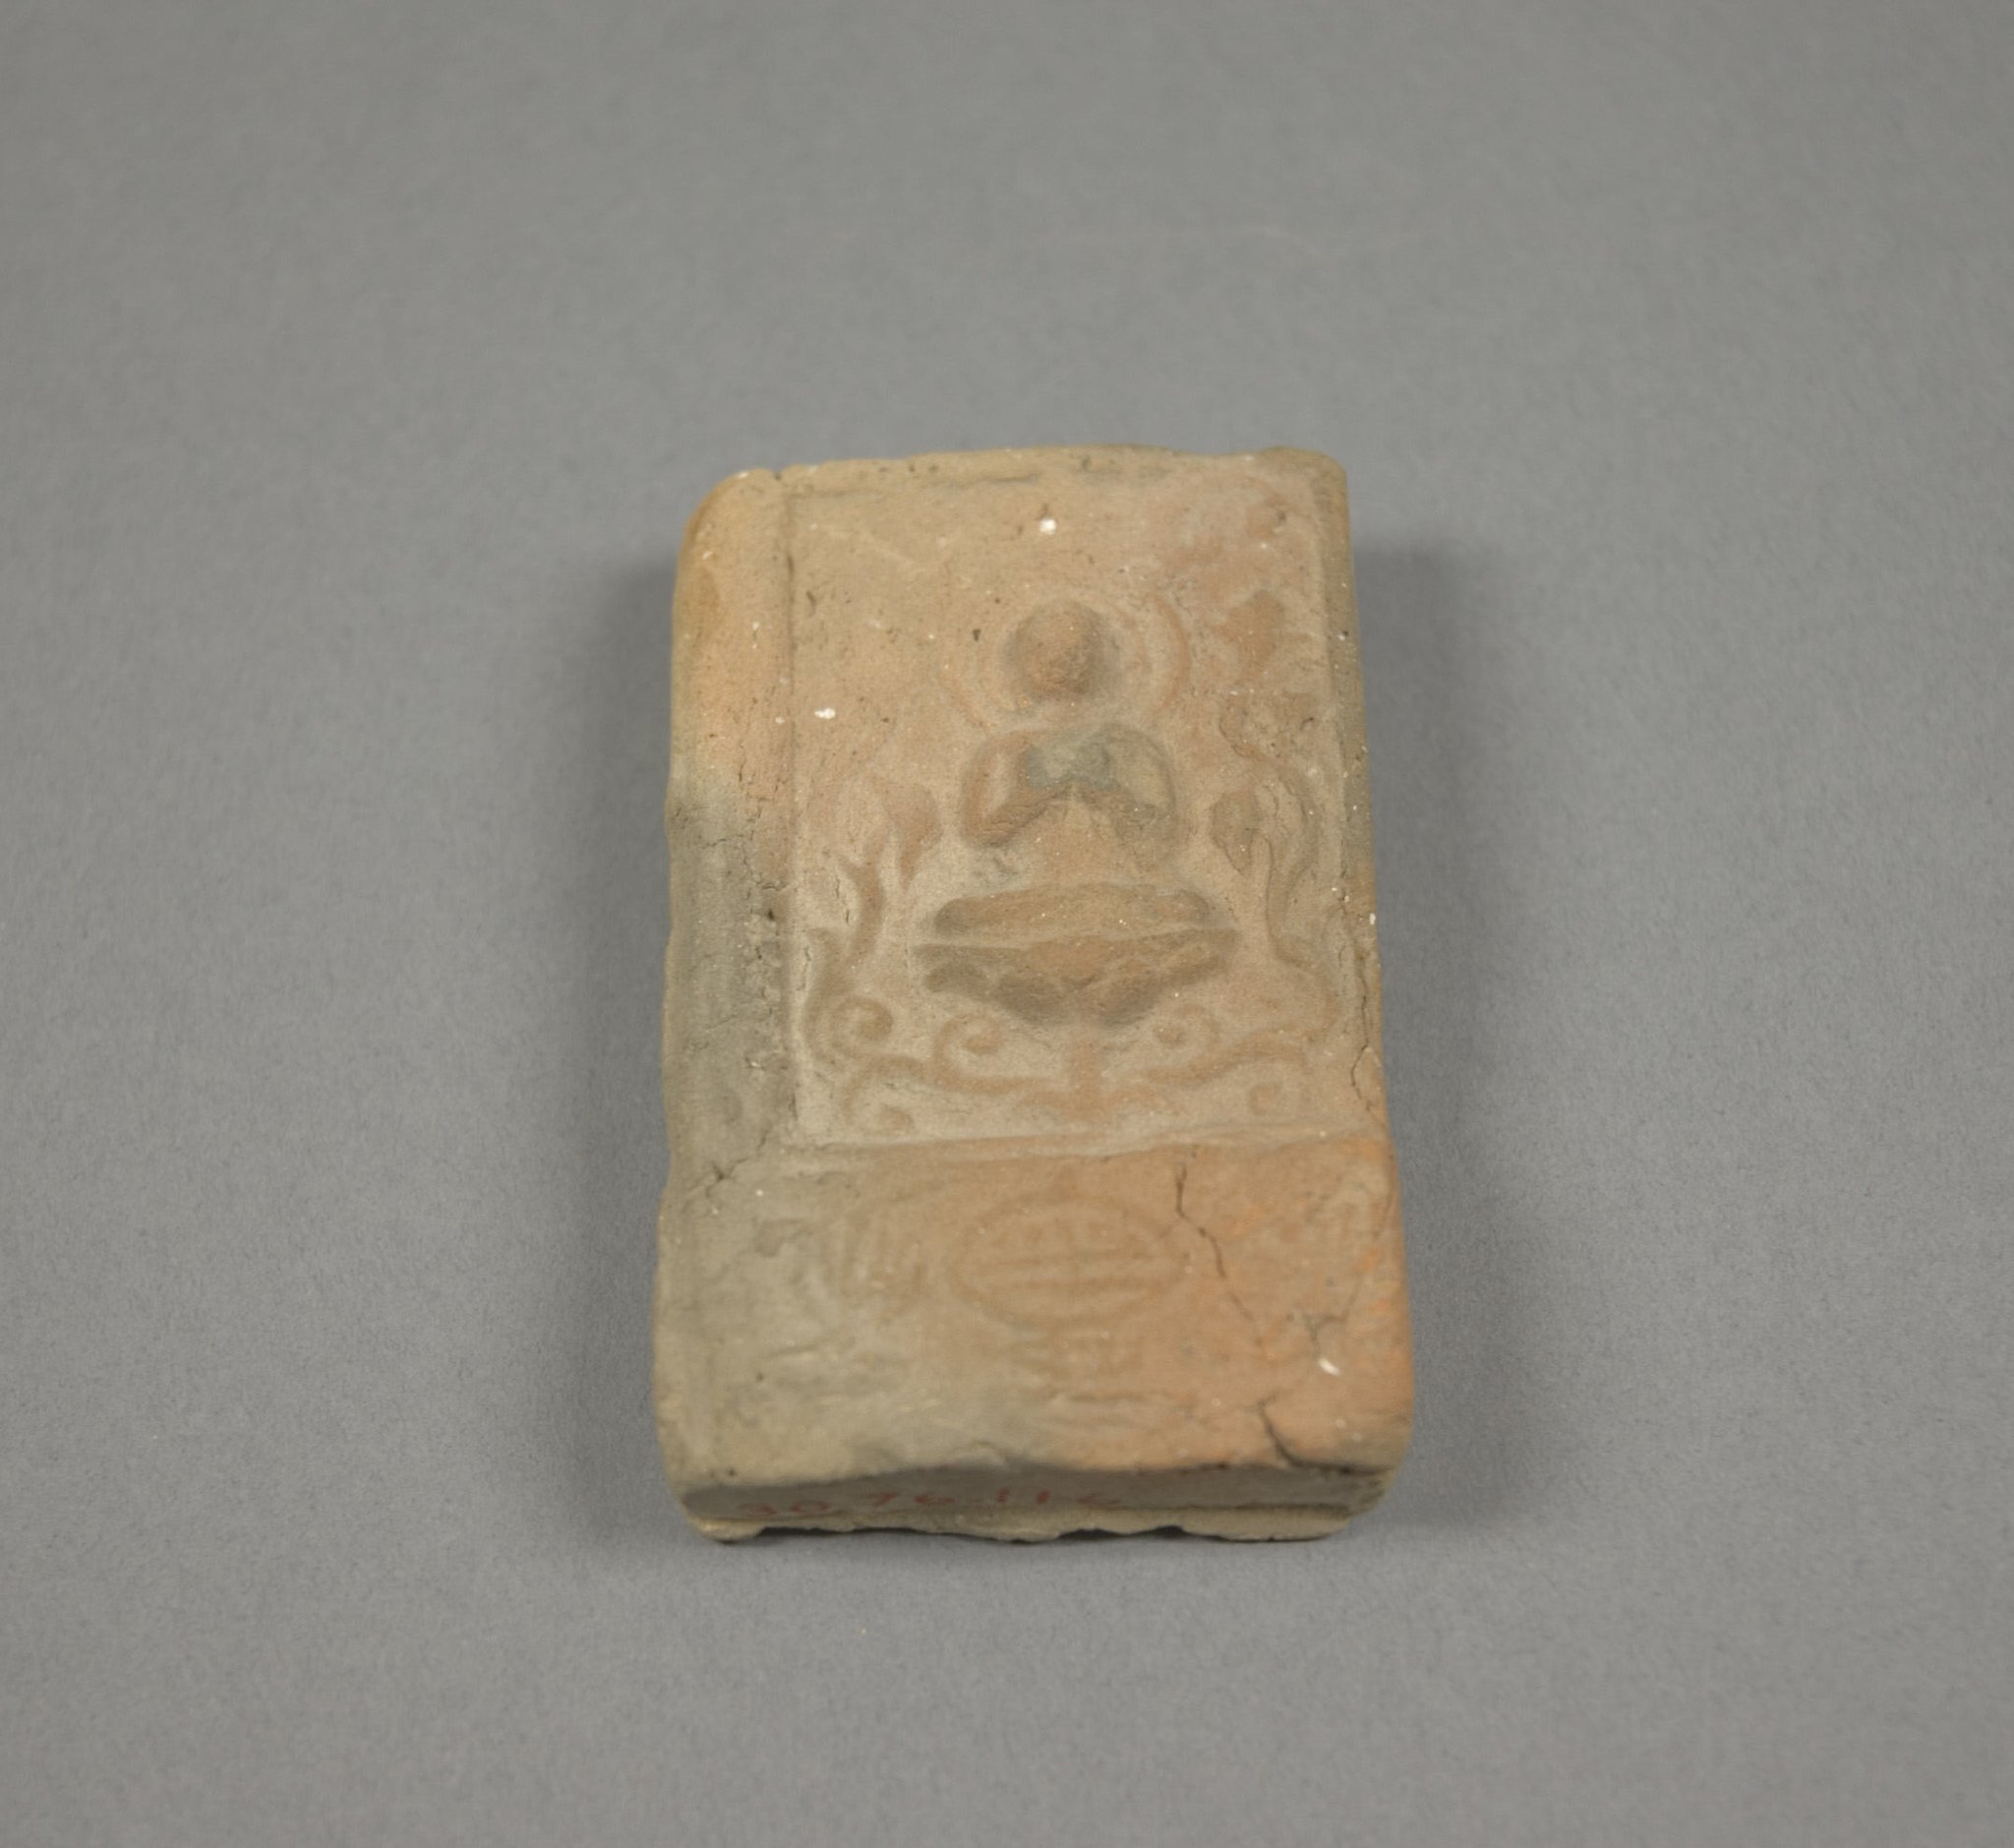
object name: votive tablet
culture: chinese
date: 618-907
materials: terracotta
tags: buddha